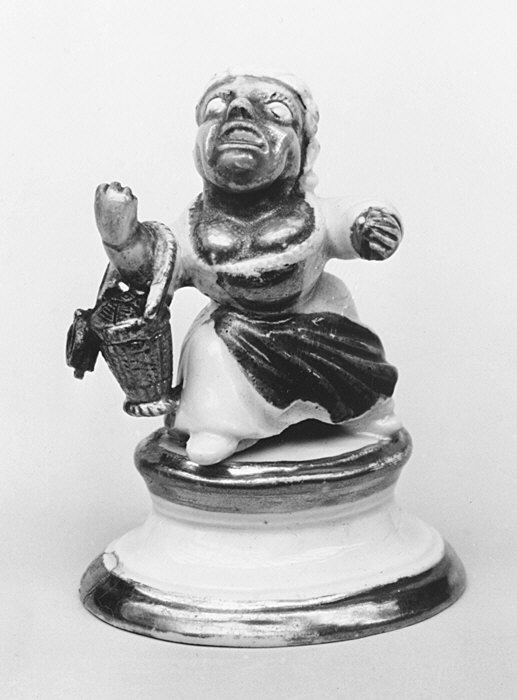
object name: figure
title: Female Callot dwarf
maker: meissen manufactory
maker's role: manufactory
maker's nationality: german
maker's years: 1710-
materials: hard paste porcelain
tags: women